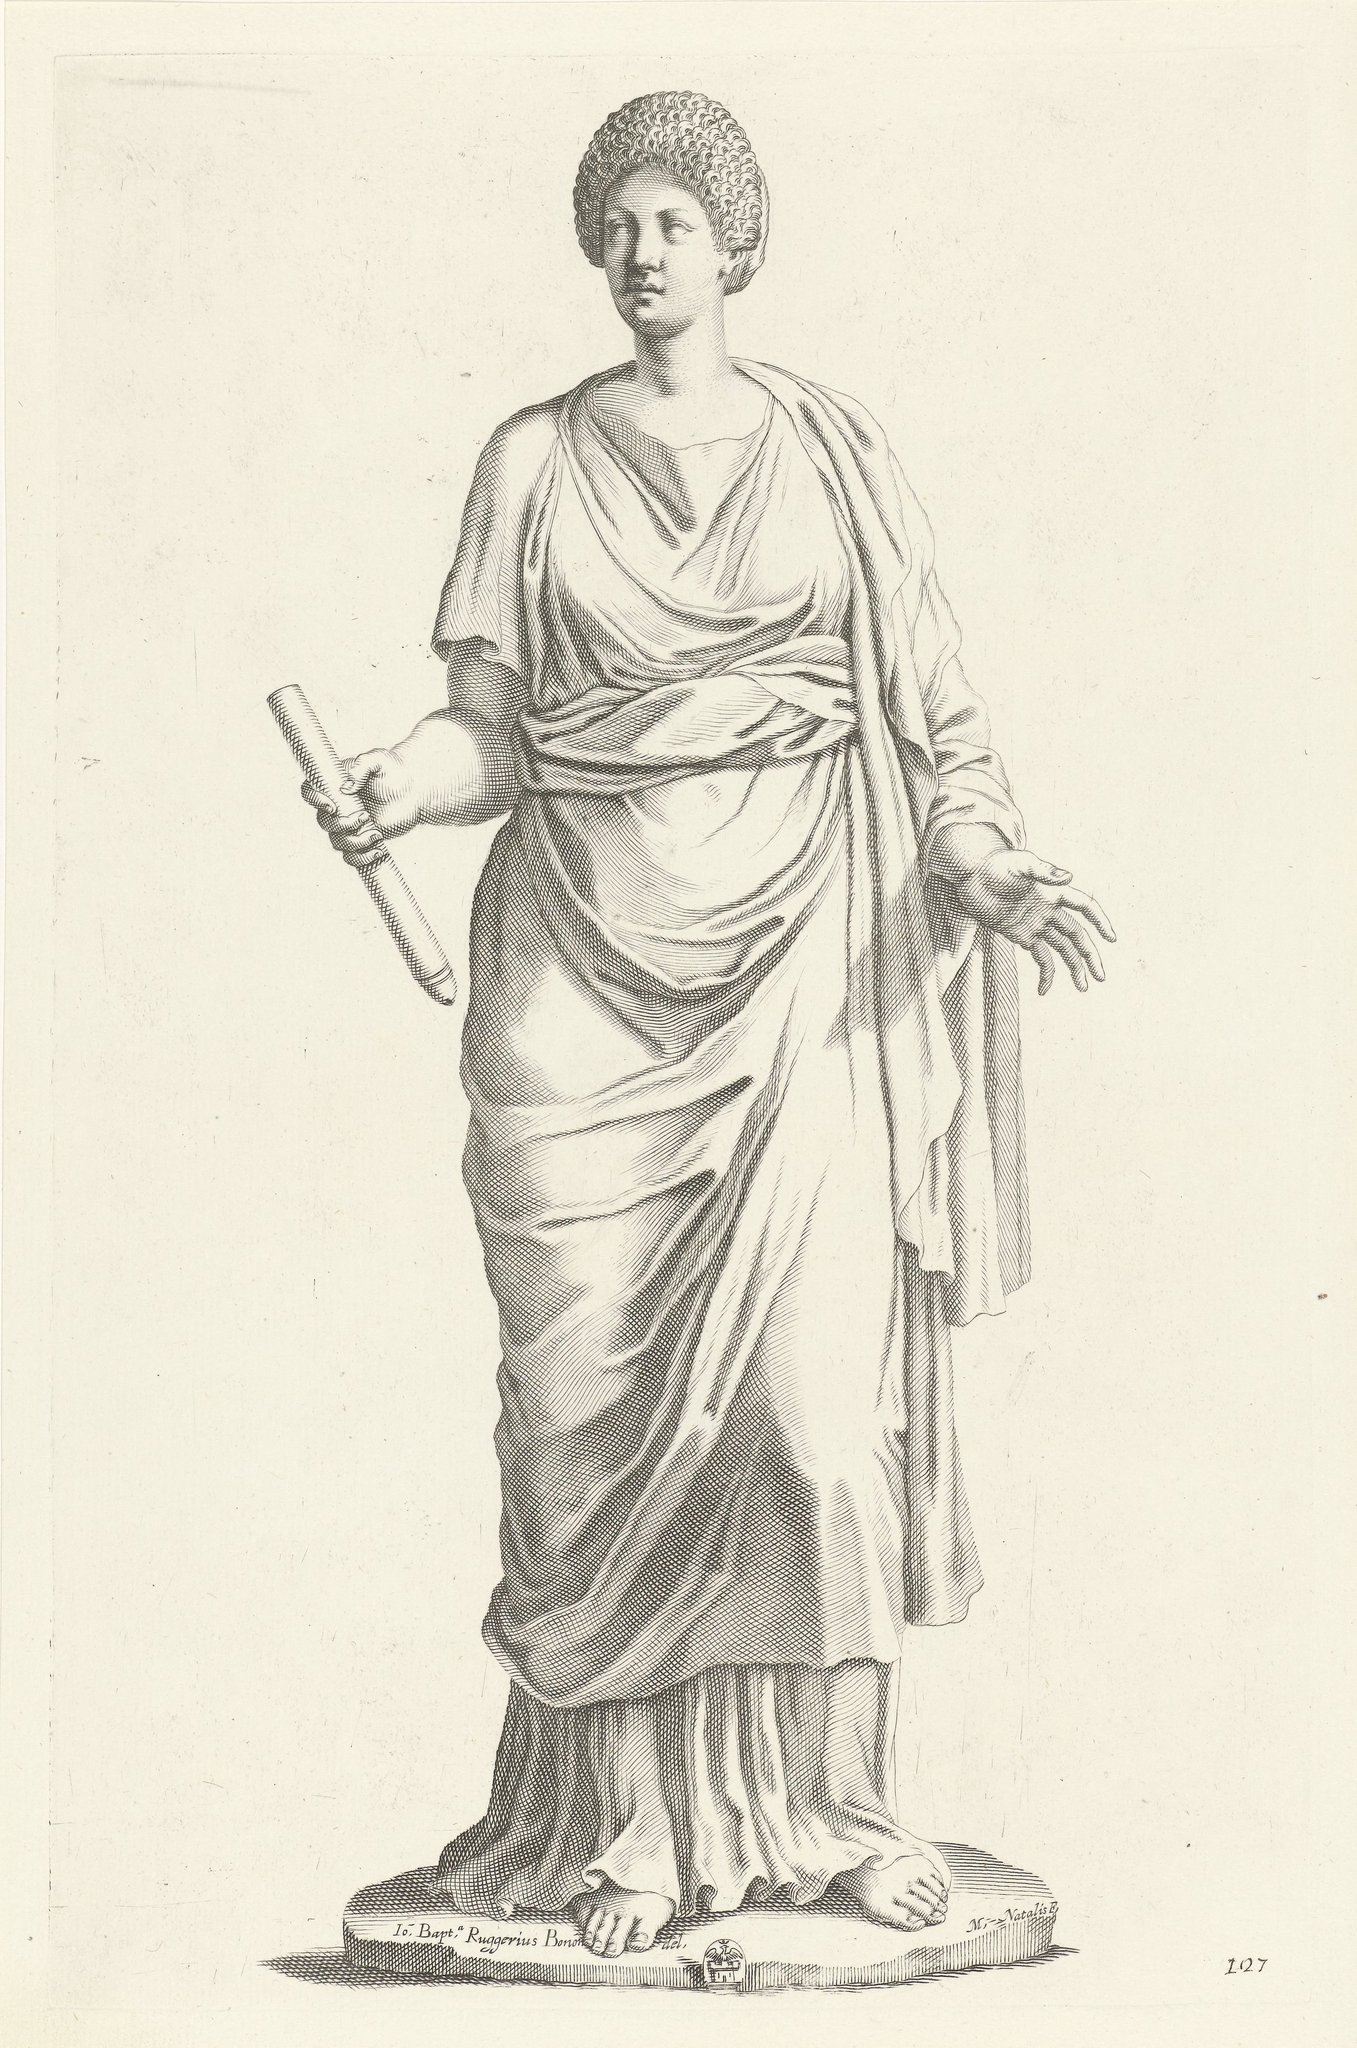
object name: print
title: Galleria Giustiniana del Marchese Vincenzo Giustiniani I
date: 1640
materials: paper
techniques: engraving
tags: vincenzo giustiniani (1564-1637), piece of sculpture, reproduction of a piece of sculpture, monument, statue, female persons from classical history (+ full length)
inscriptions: collector's mark: Lugt 2228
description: Standbeeld van een staande vrouw, gekleed in klassiek gewaad, met een staf in haar rechterhand. Midden onder op de basis het wapenschild van Vincenzo Giustiniani. Prent uit een serie naar de sculpturen in de verzameling in de Galleria Giustiniani te Rome.